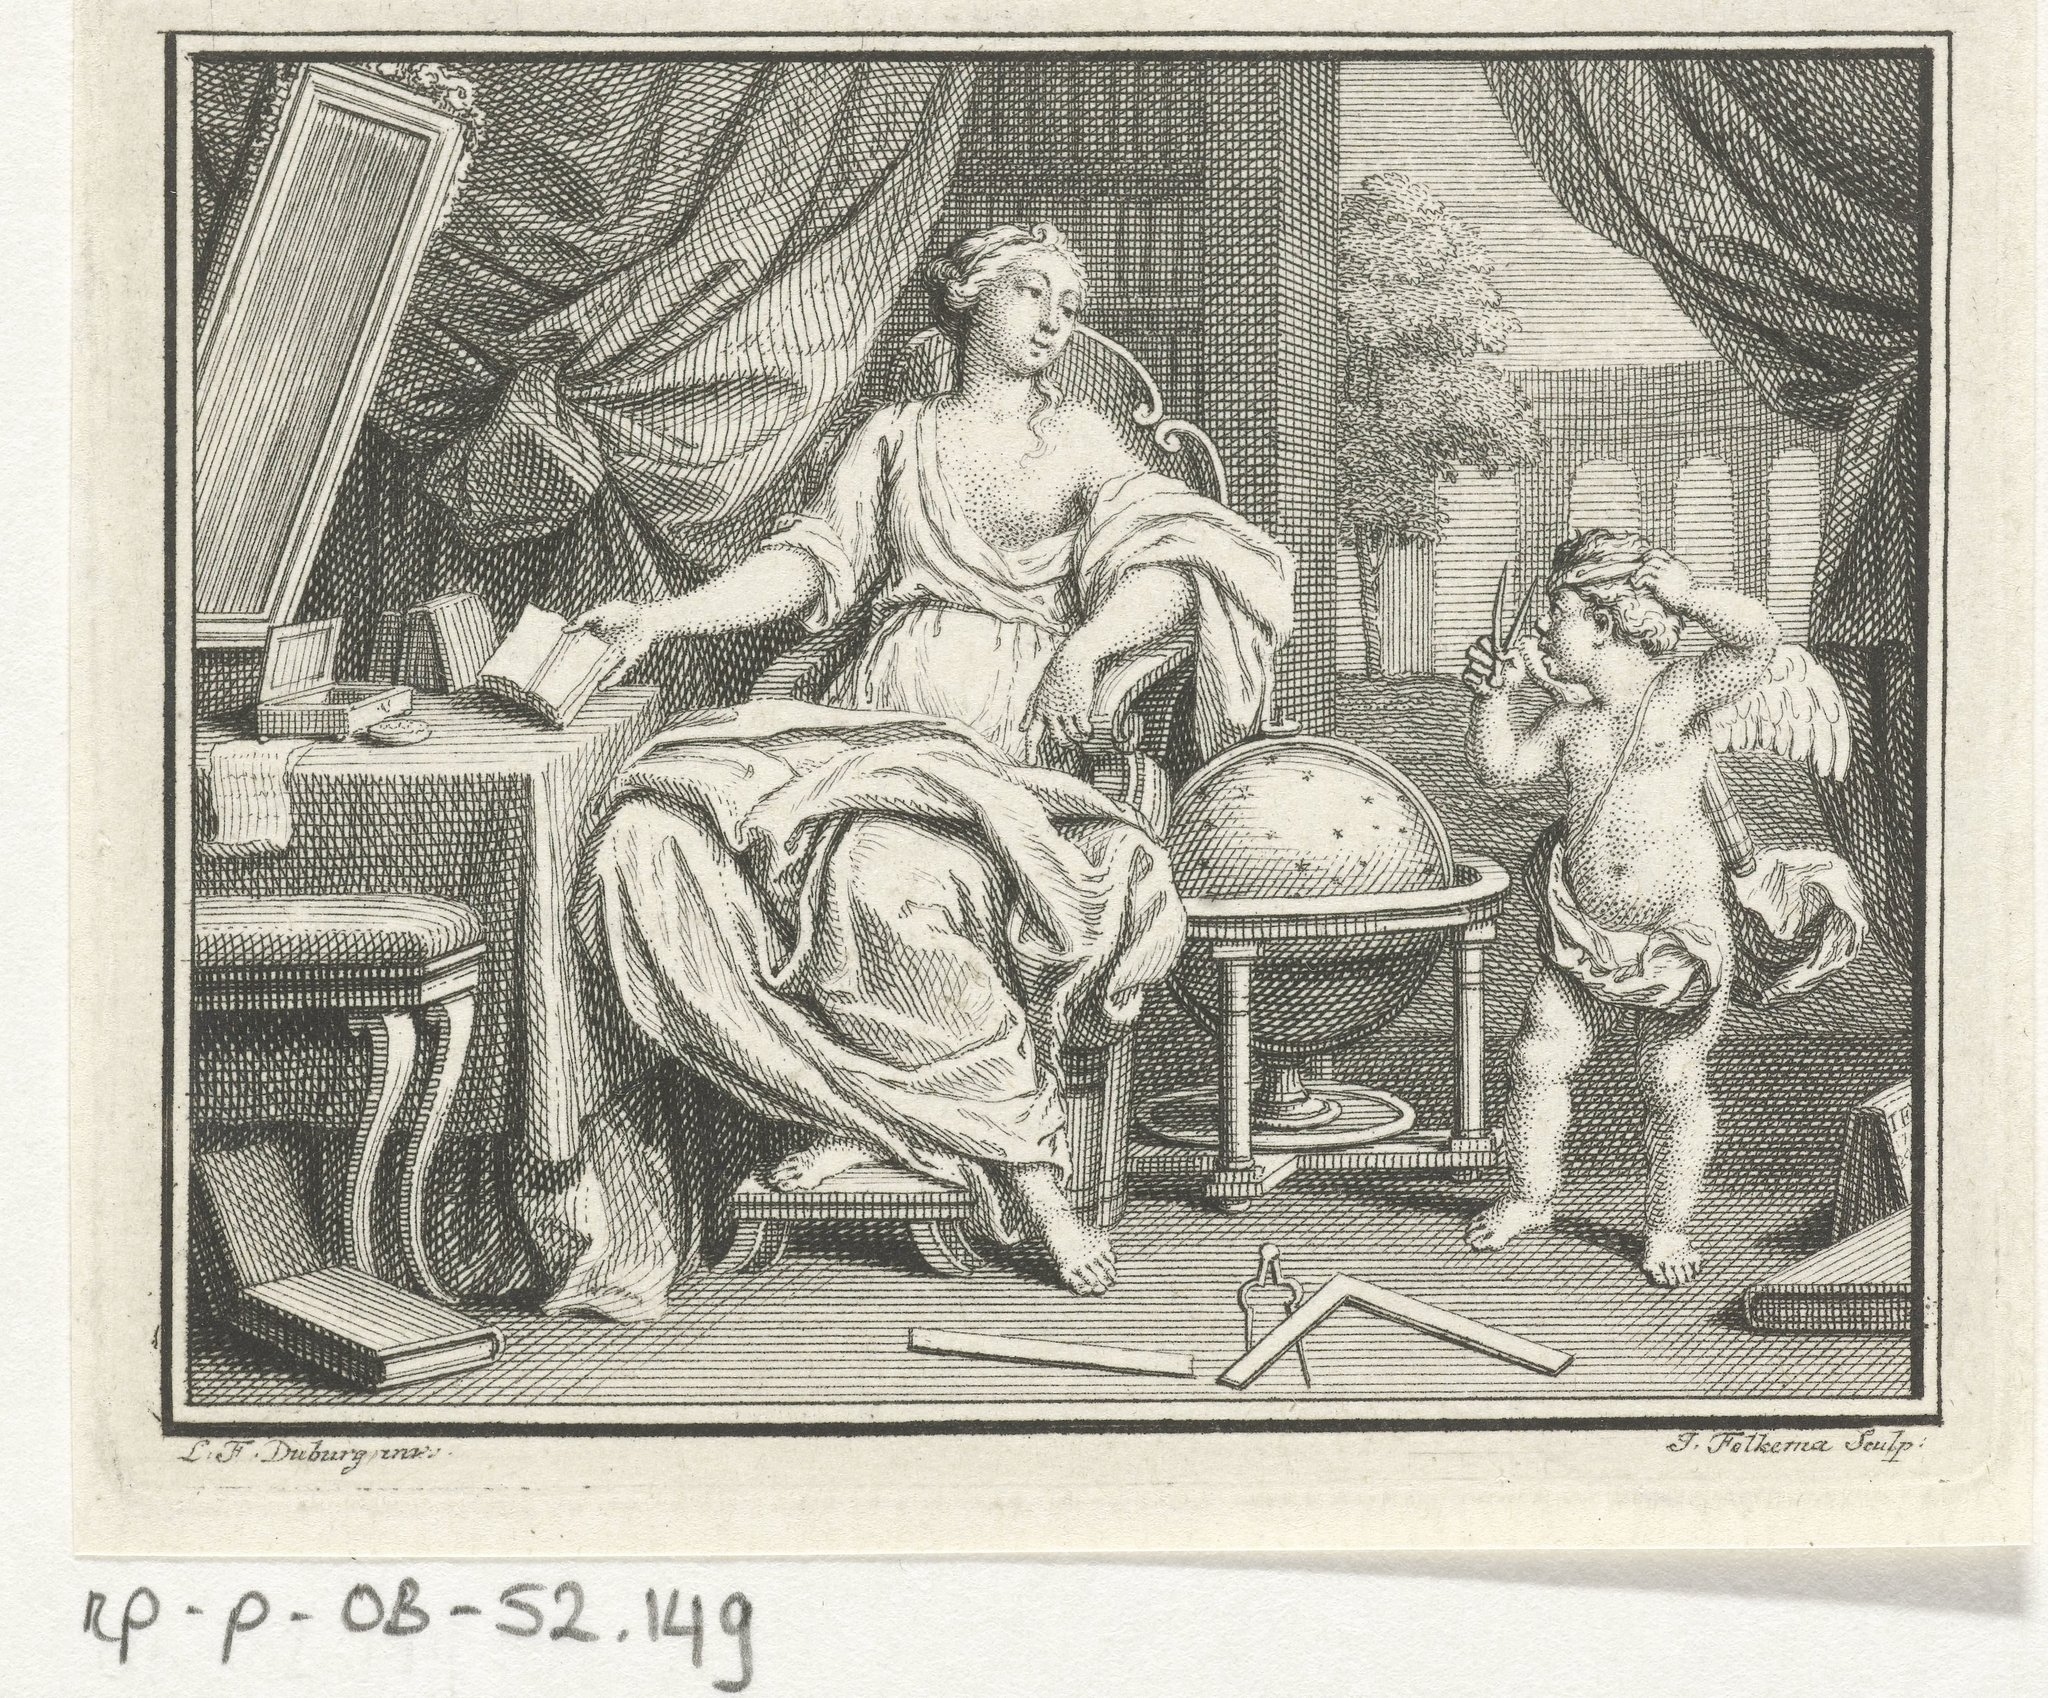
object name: print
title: Astronomie in een vertrek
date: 1703-1767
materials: paper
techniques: etching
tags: 'astronomia', 'cosmografia'; 'cosmografia' (ripa), cupids: 'amores', 'amoretti', 'putti'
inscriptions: collector's mark: Lugt 240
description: De personificatie van Astronomie, een van de Zeven Vrije Kunsten, zit in een vertrek achter een tafel waar boeken op liggen. Naast haar staat een globe, op de grond liggen meetinstrumenten en boeken. Astronomie wordt vergezeld door een putto die met een passer speelt.